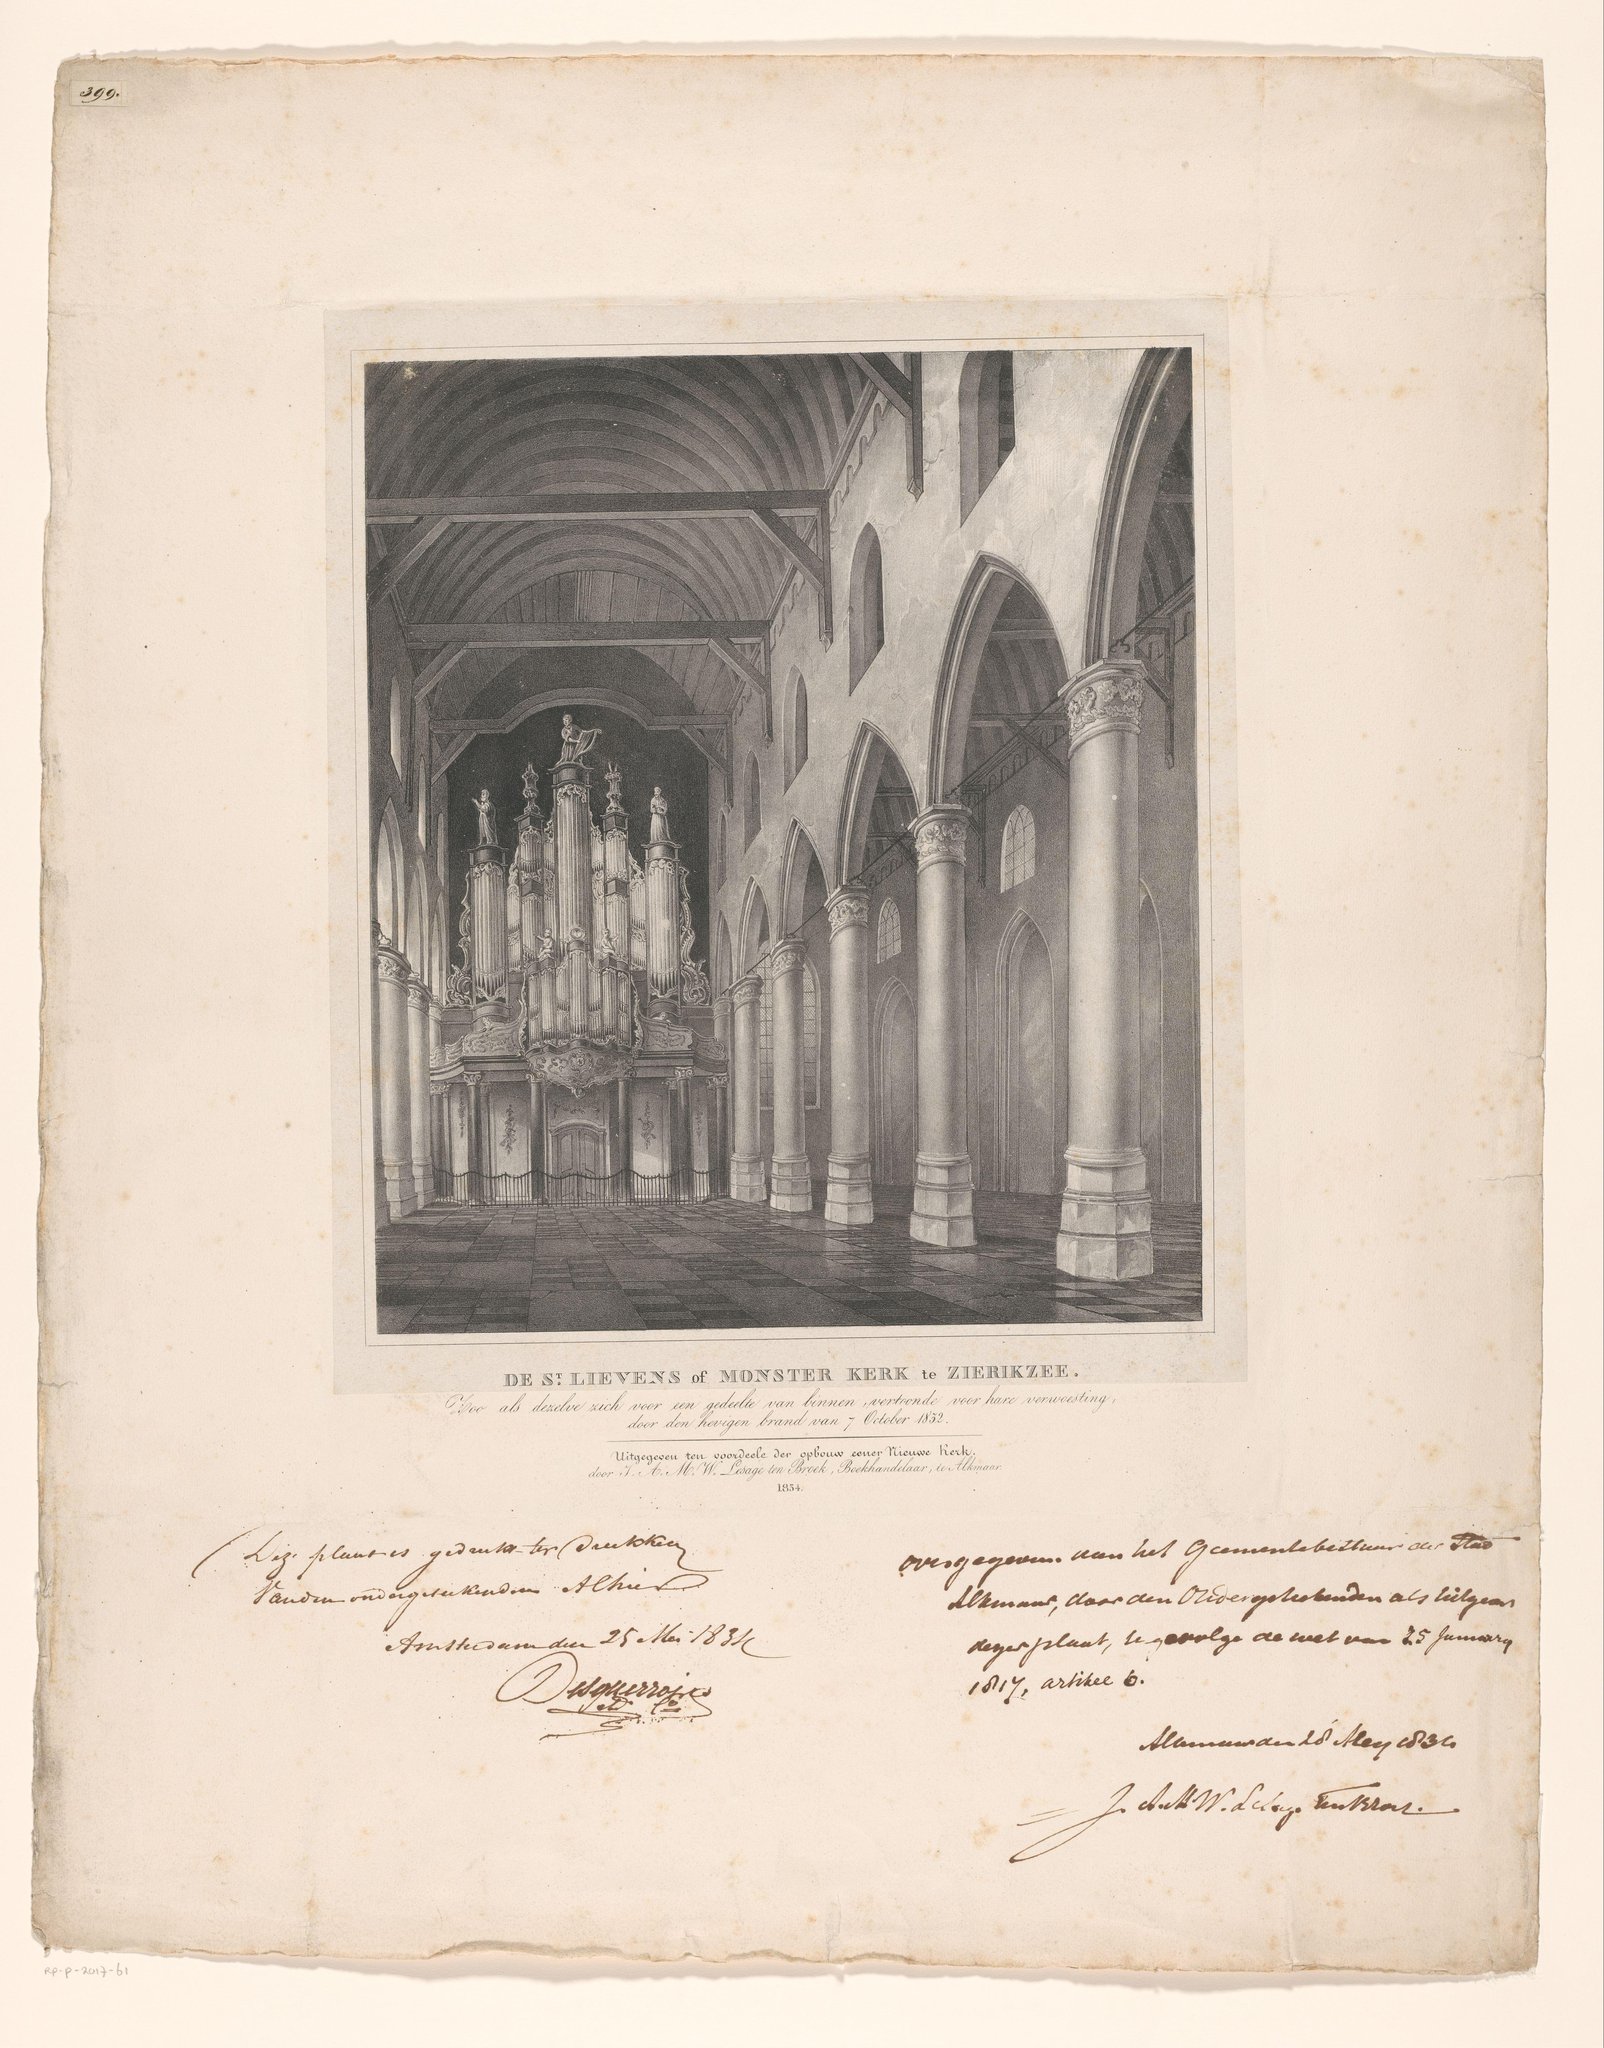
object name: print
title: De St. Lievens of Monster Kerk te Zierikzee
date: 1834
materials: paper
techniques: lithograph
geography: zierikzee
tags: church organ, parts of church interior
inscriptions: : ‘Overgegeven aan het gemeentebestuur der stad / Alkmaar, daar den ondergeteekenden als uitgevers / dezer plaat, te gevolge de wet van 25 january / 1817, artikel 6 / Alkmaar 28 mei 1834 / J.A.M.W. Lesage ten Broek’, : ‘Deze Plaat is gedrukt ter drukkerij / van den ondergeteekenden alhier / Amsterdam den 25 mei 1834 / Desguerrois & Co’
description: Interieur van de Sint-Lievensmonsterkerk te Zierikzee, in welstand, vóór de brand van 6 oktober 1832. Gezicht van het interieur naar het orgel toe. De kerk heeft een houten plafond. Rechts een zijbeuk, gescheiden van het schip door zuilen.